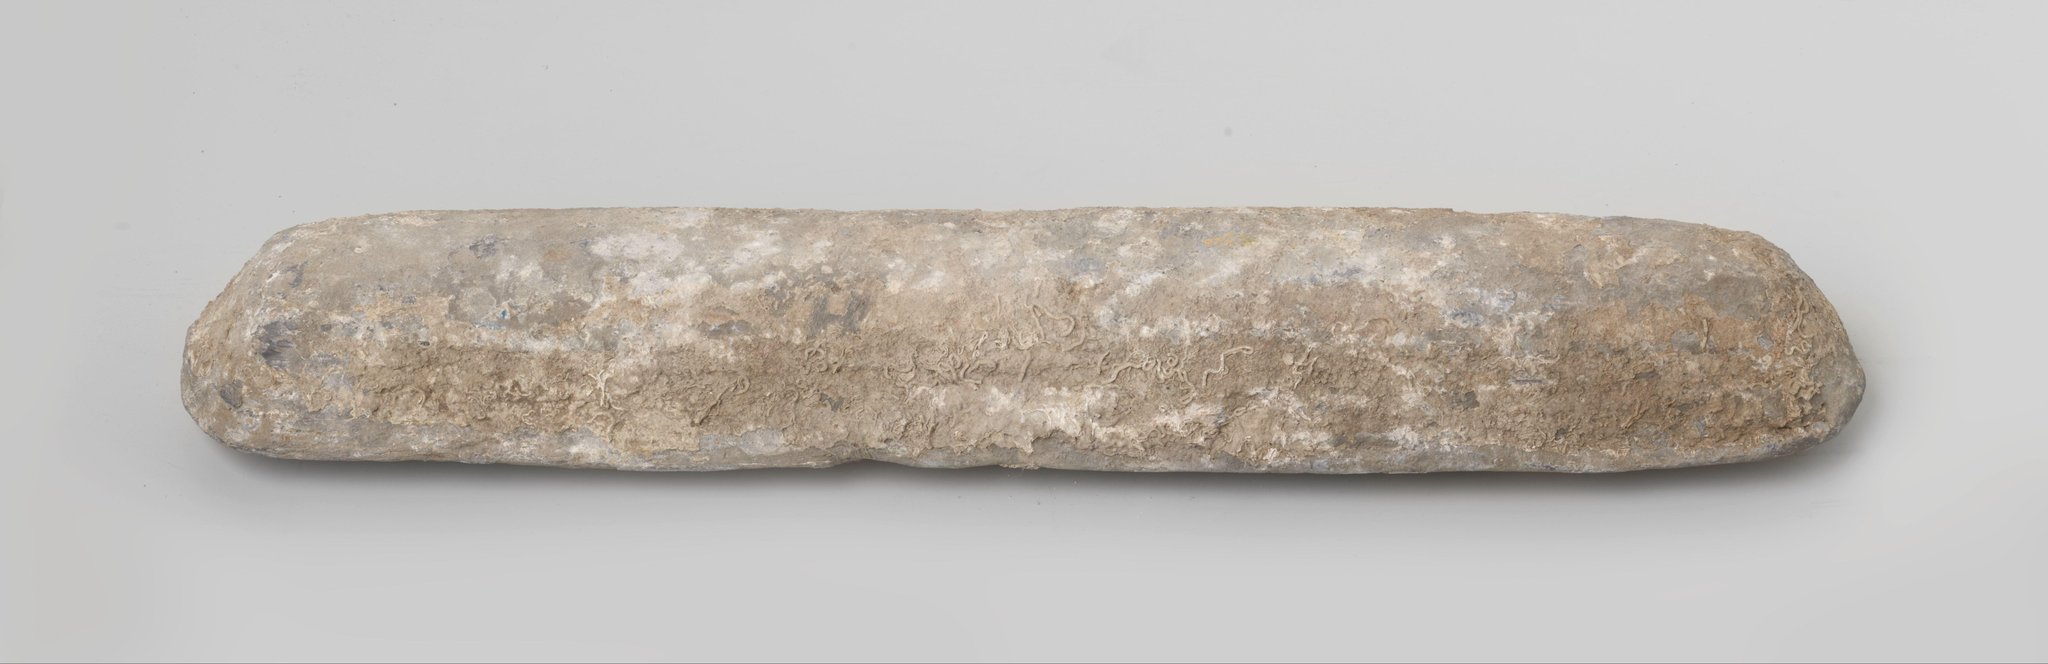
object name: ingot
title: Ballastlood uit het wrak van de Oost-Indiëvaarder Hollandia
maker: Anonymous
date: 1700-1743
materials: lead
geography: netherlands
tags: verenigde oostindische compagnie, hollandia (schip), annet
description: Ingot; (1) corroded, oblong, semicircular slightly tapered ends, flat upper side (80l, 13.5-14.4w, 7.8h), tapered underside, marks legible on top [AM].